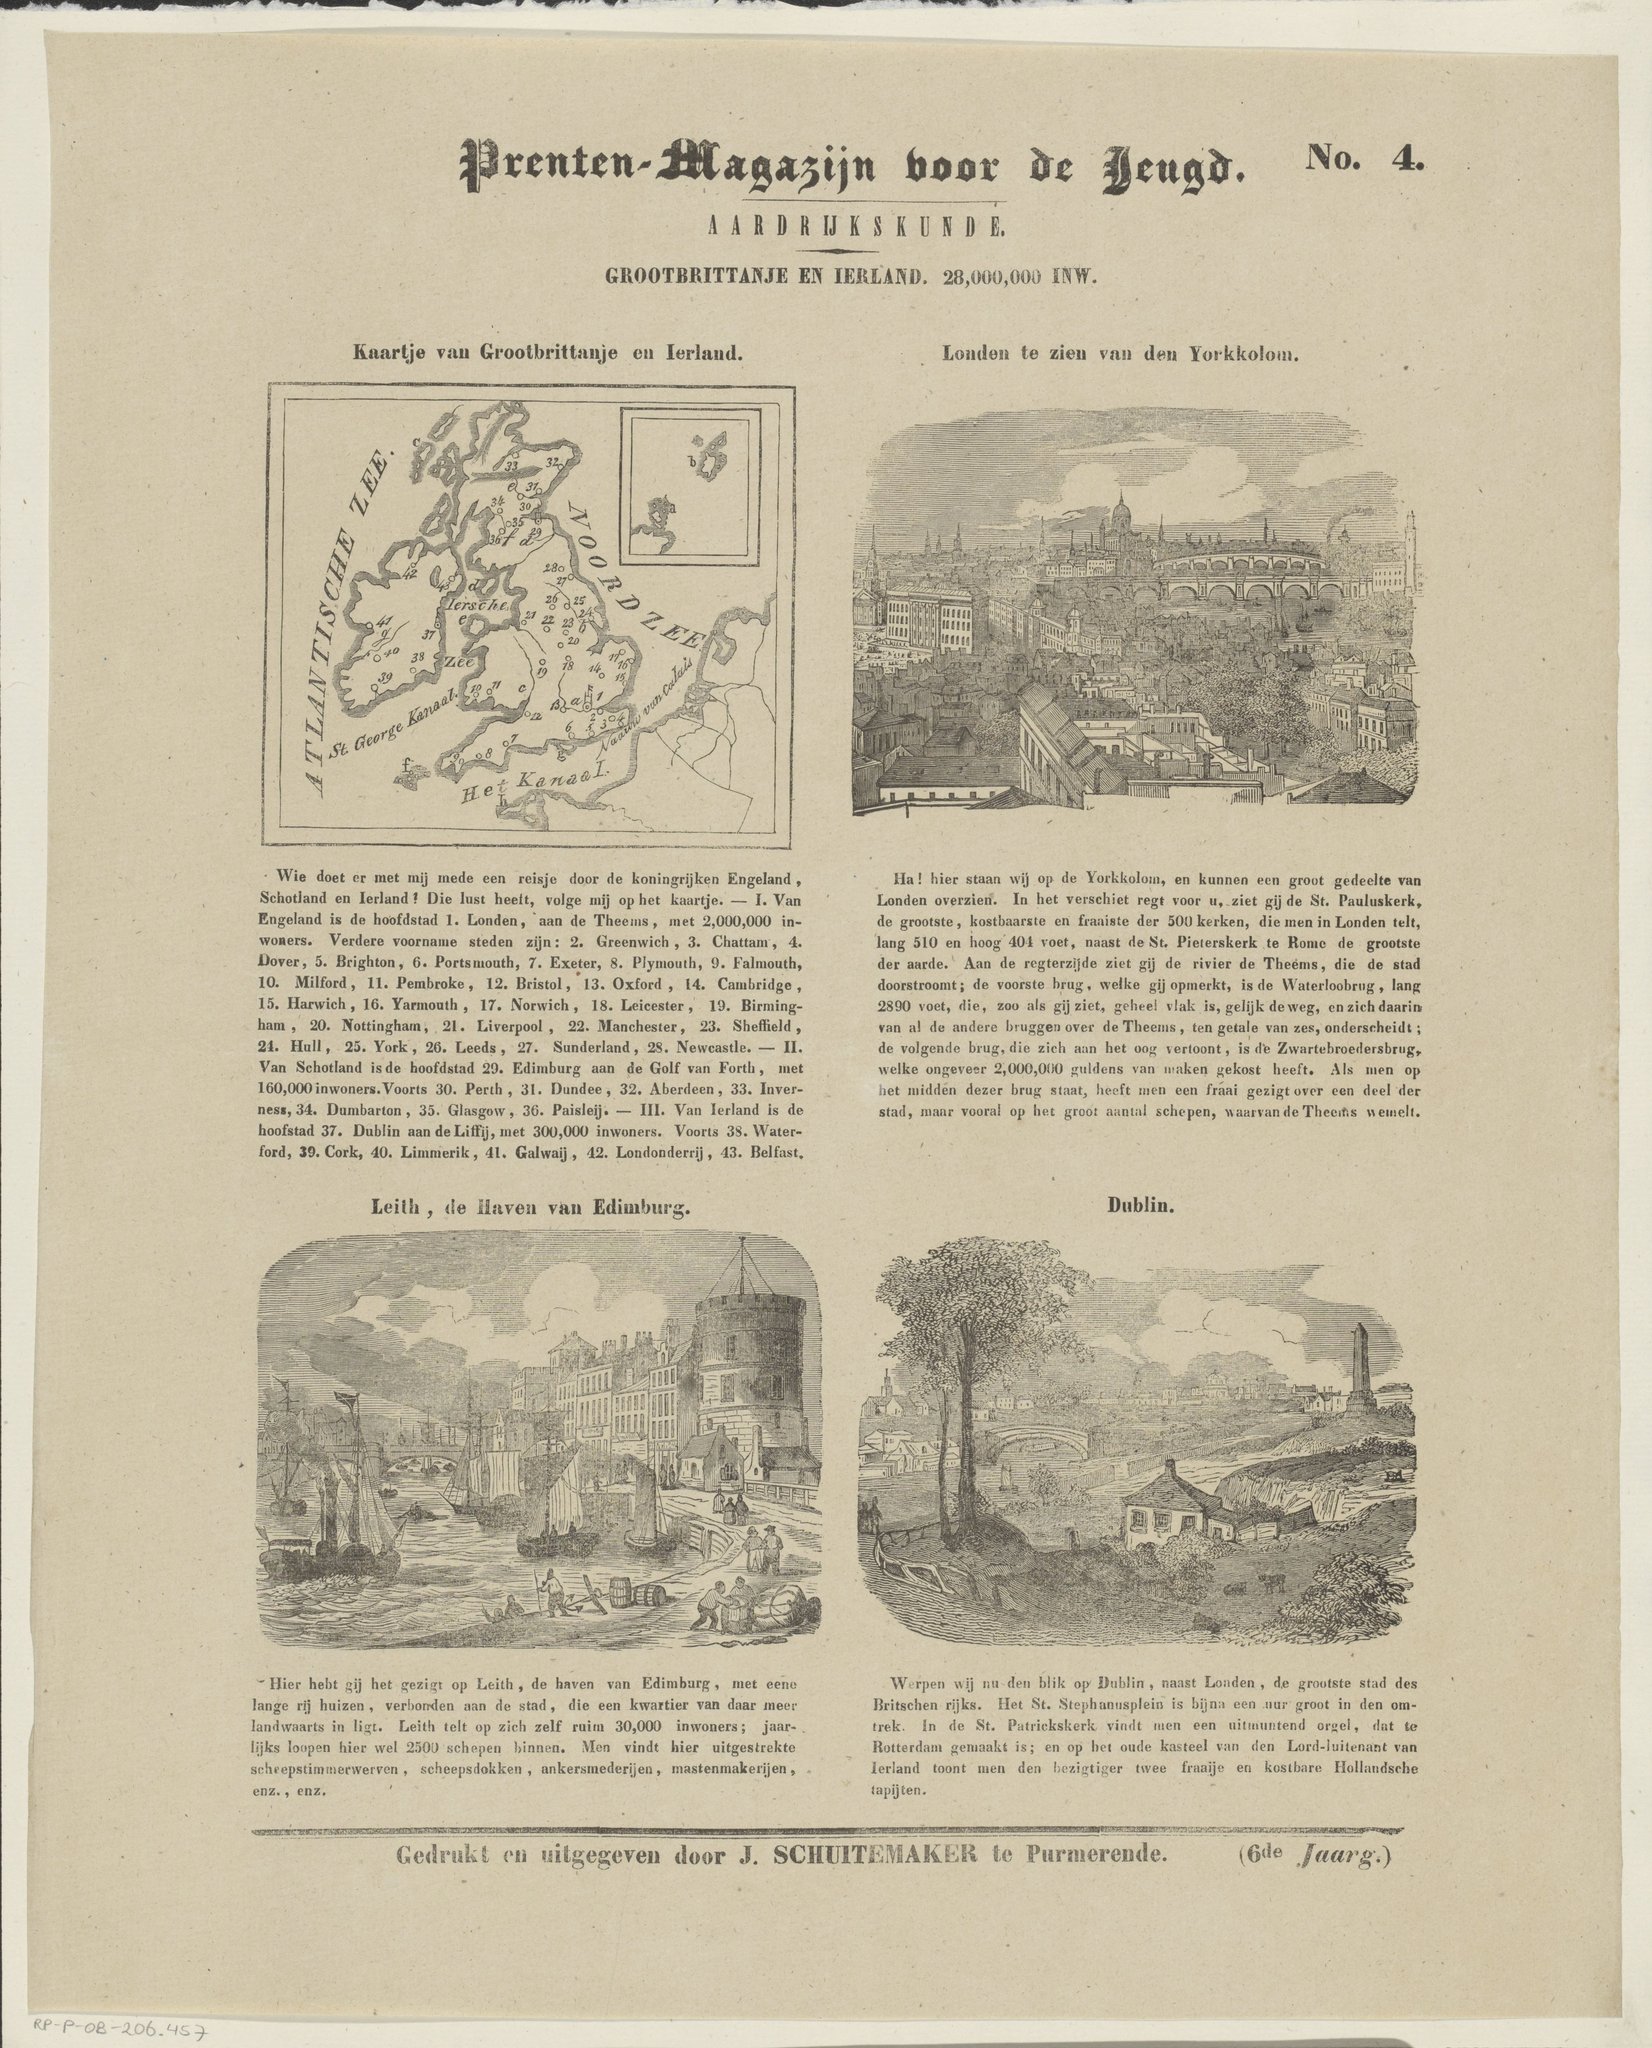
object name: print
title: Aardrijkskunde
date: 1847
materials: paper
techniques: letterpress printing, engraving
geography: purmerend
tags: maps, atlases, great britain, london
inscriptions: collector's mark: Lugt 2760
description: Blad met 4 voorstellingen over Groot-Brittannië en Ierland met een kaart en belangrijke steden: Londen, Edinburgh en Dublin. Boven elke voorstelling een titel en onder elke voorstelling een onderschrift. Genummerd rechtsboven: No. 4.